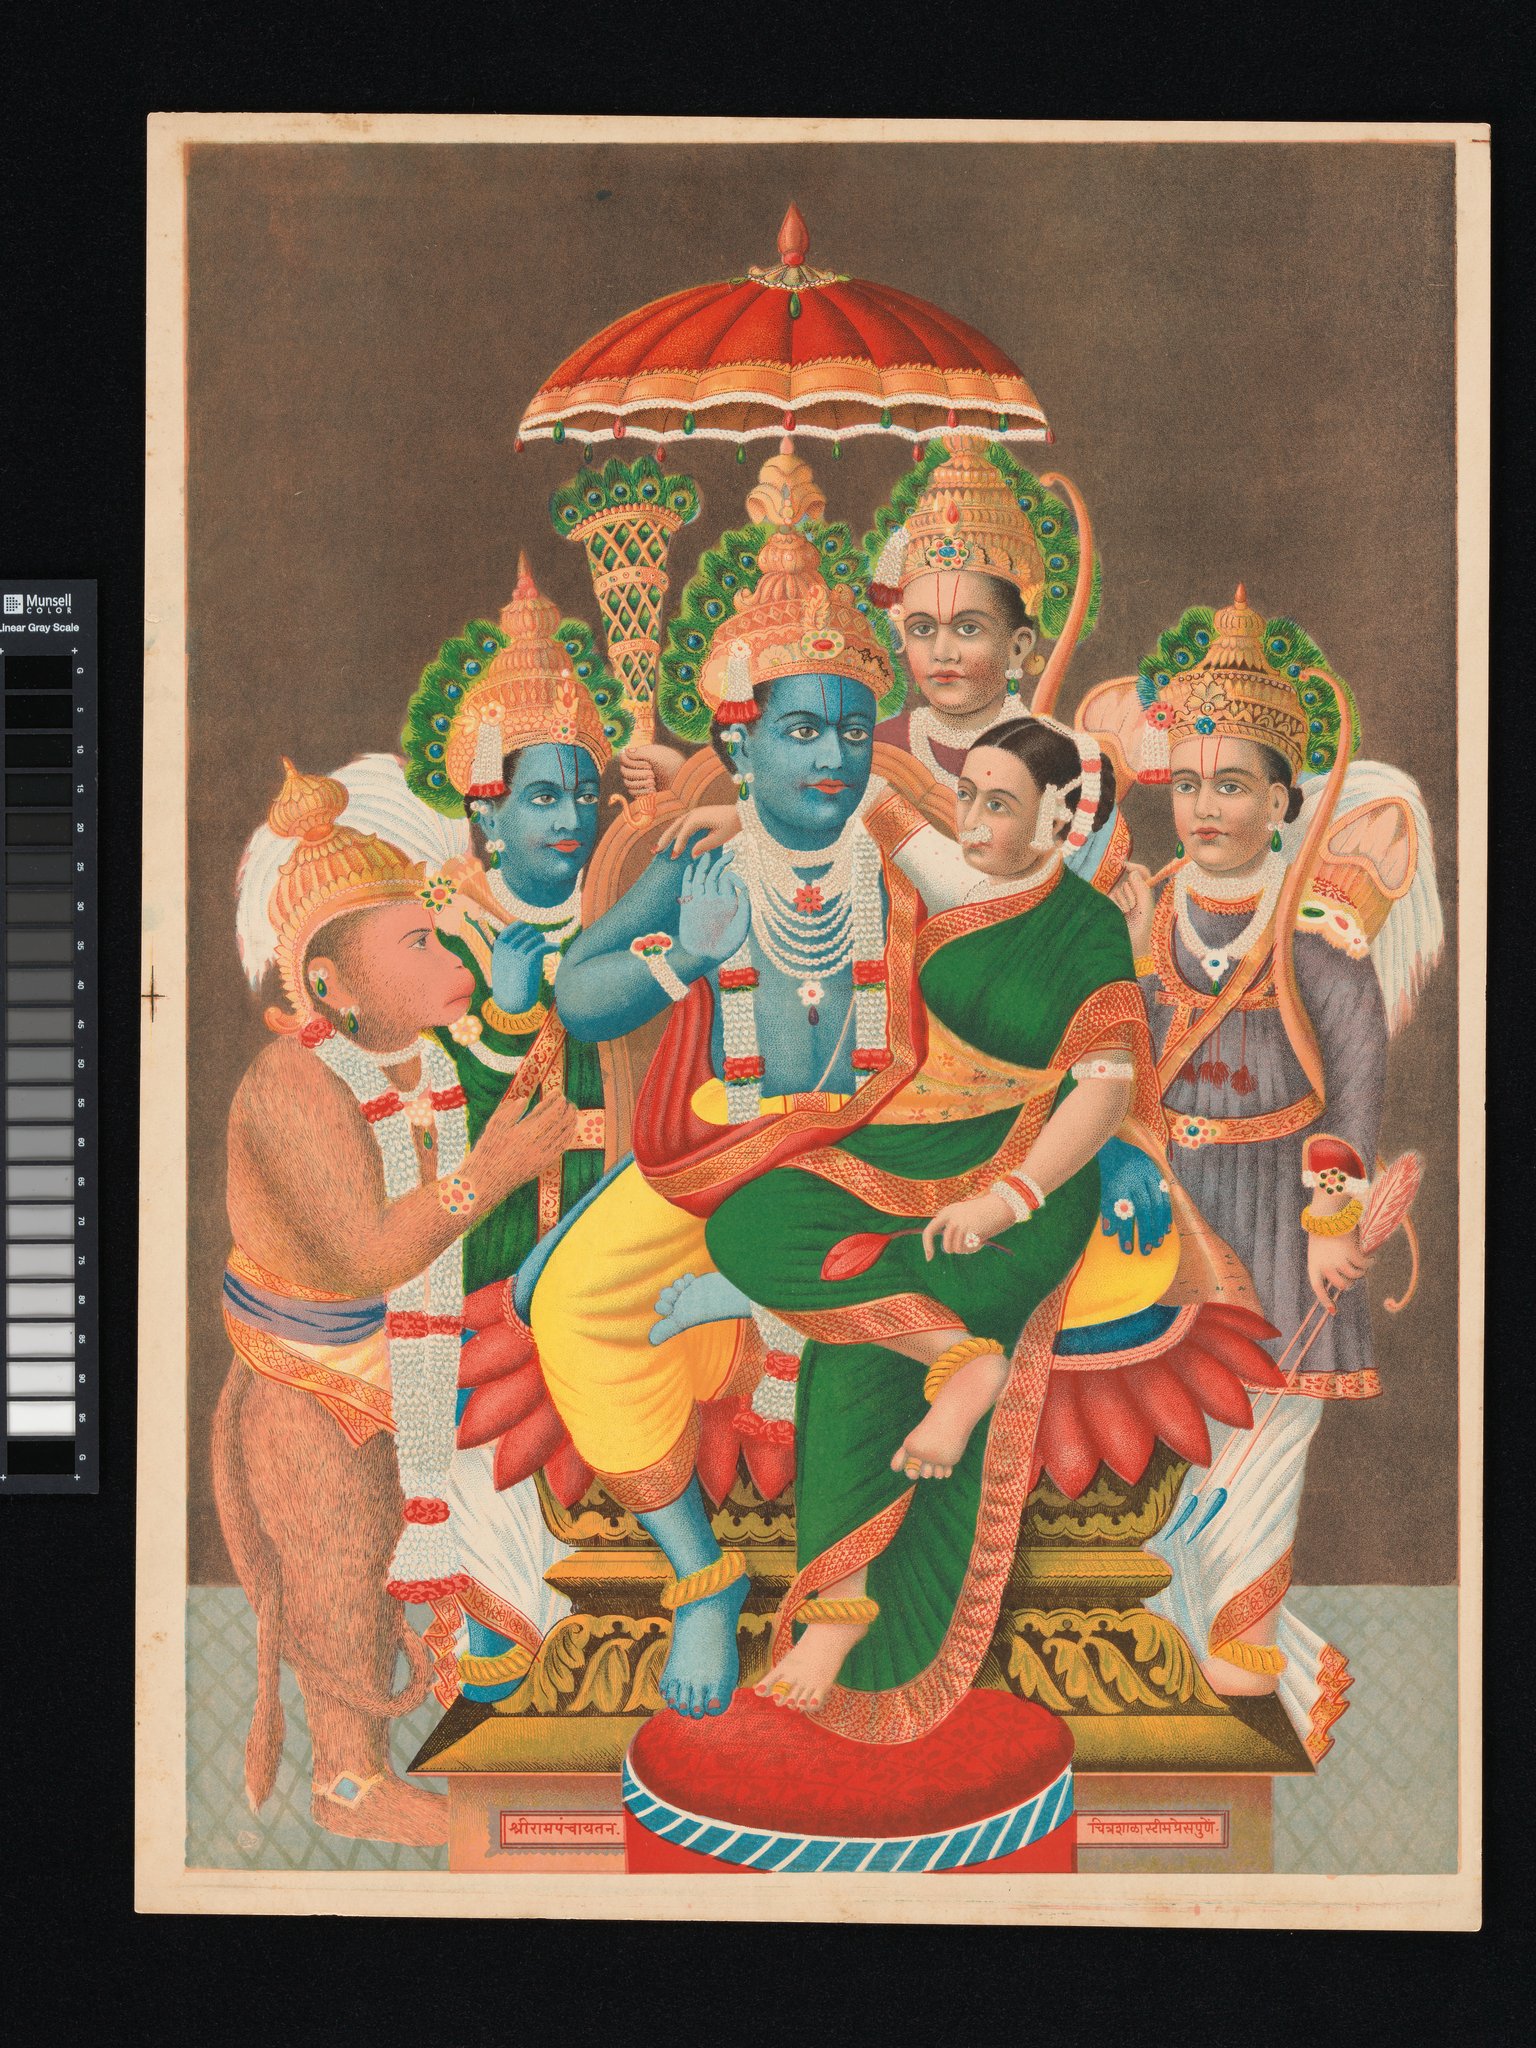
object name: print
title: Rampanchayatam (Ram’s assembly)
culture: indian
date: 1878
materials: chromolithograph, paper